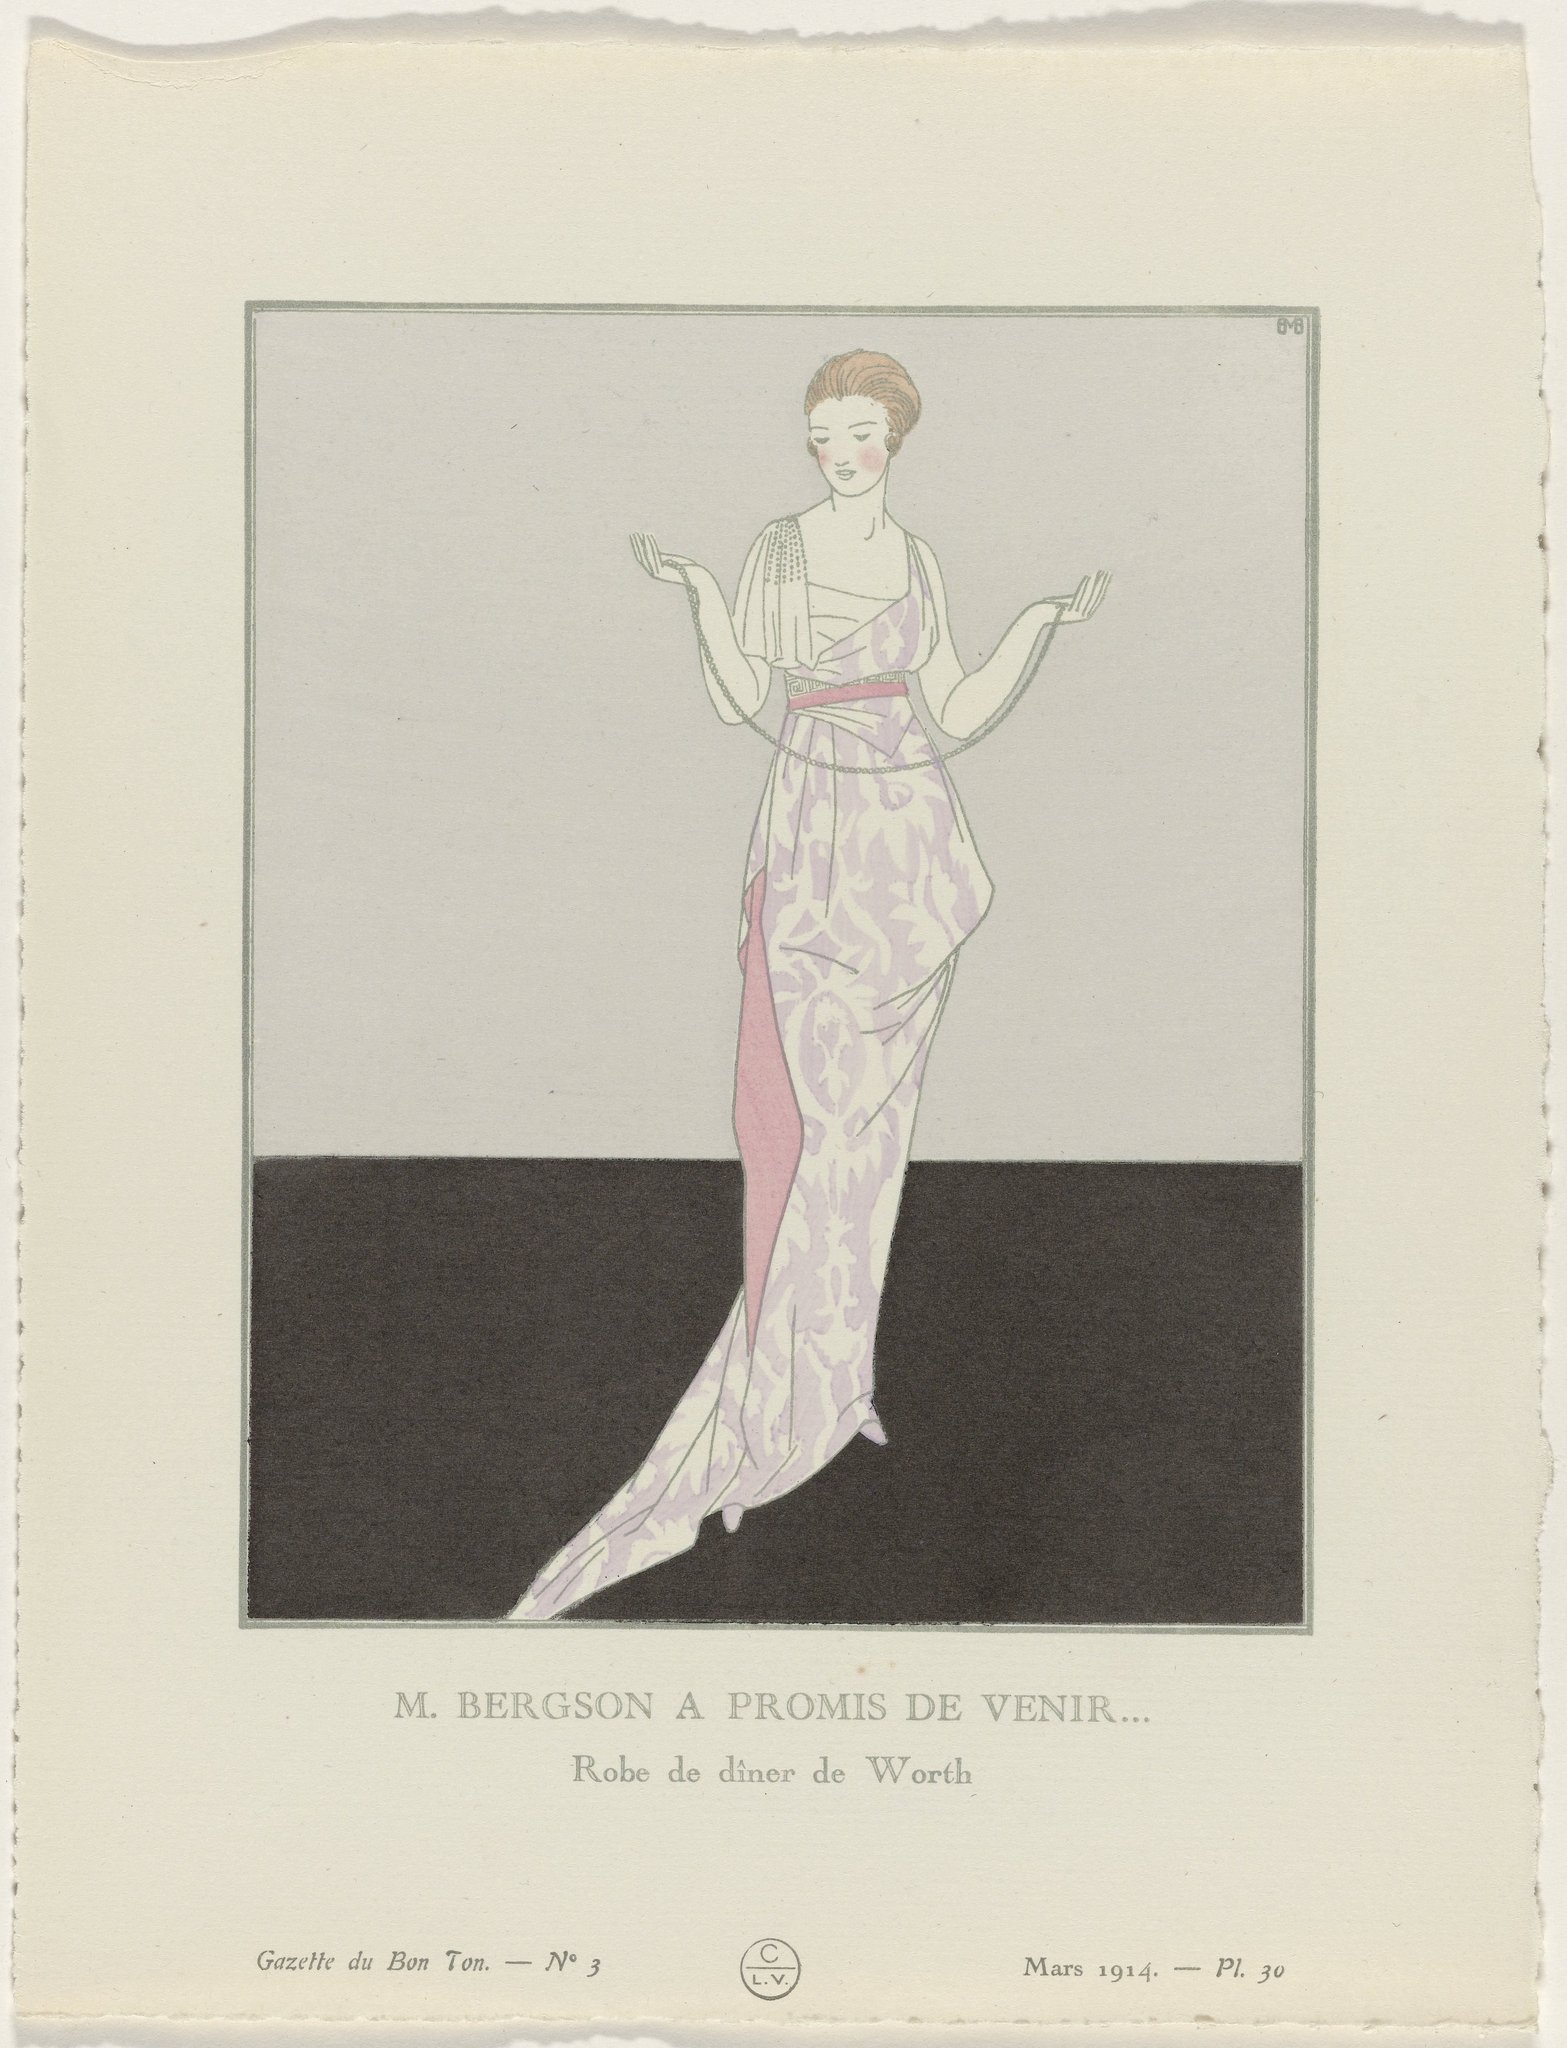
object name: fashion print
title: Gazette du Bon Ton, 1914 - No. 3, Pl. 30: M. Bergson a promis de venir (...) / Robe de dîner de Worth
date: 1914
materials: paper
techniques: hand coloring, letterpress printing, lithograph, pochoir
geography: paris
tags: embroidery (ornamentation) (+ women's clothes), dress, gown: dinner dress (+ women's clothes), fashion plates, necklace (+ women's clothes)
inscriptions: date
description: Staande vrouw gekleed in een damasten lila dinerjapon met zilverlamé van Worth. Om de taille een ceintuur geborduurd met diamanten. Planche 30 uit Gazette du Bon Ton 1914, No. 3. Uitleg over de kleding op pagina "Explication des Planches".